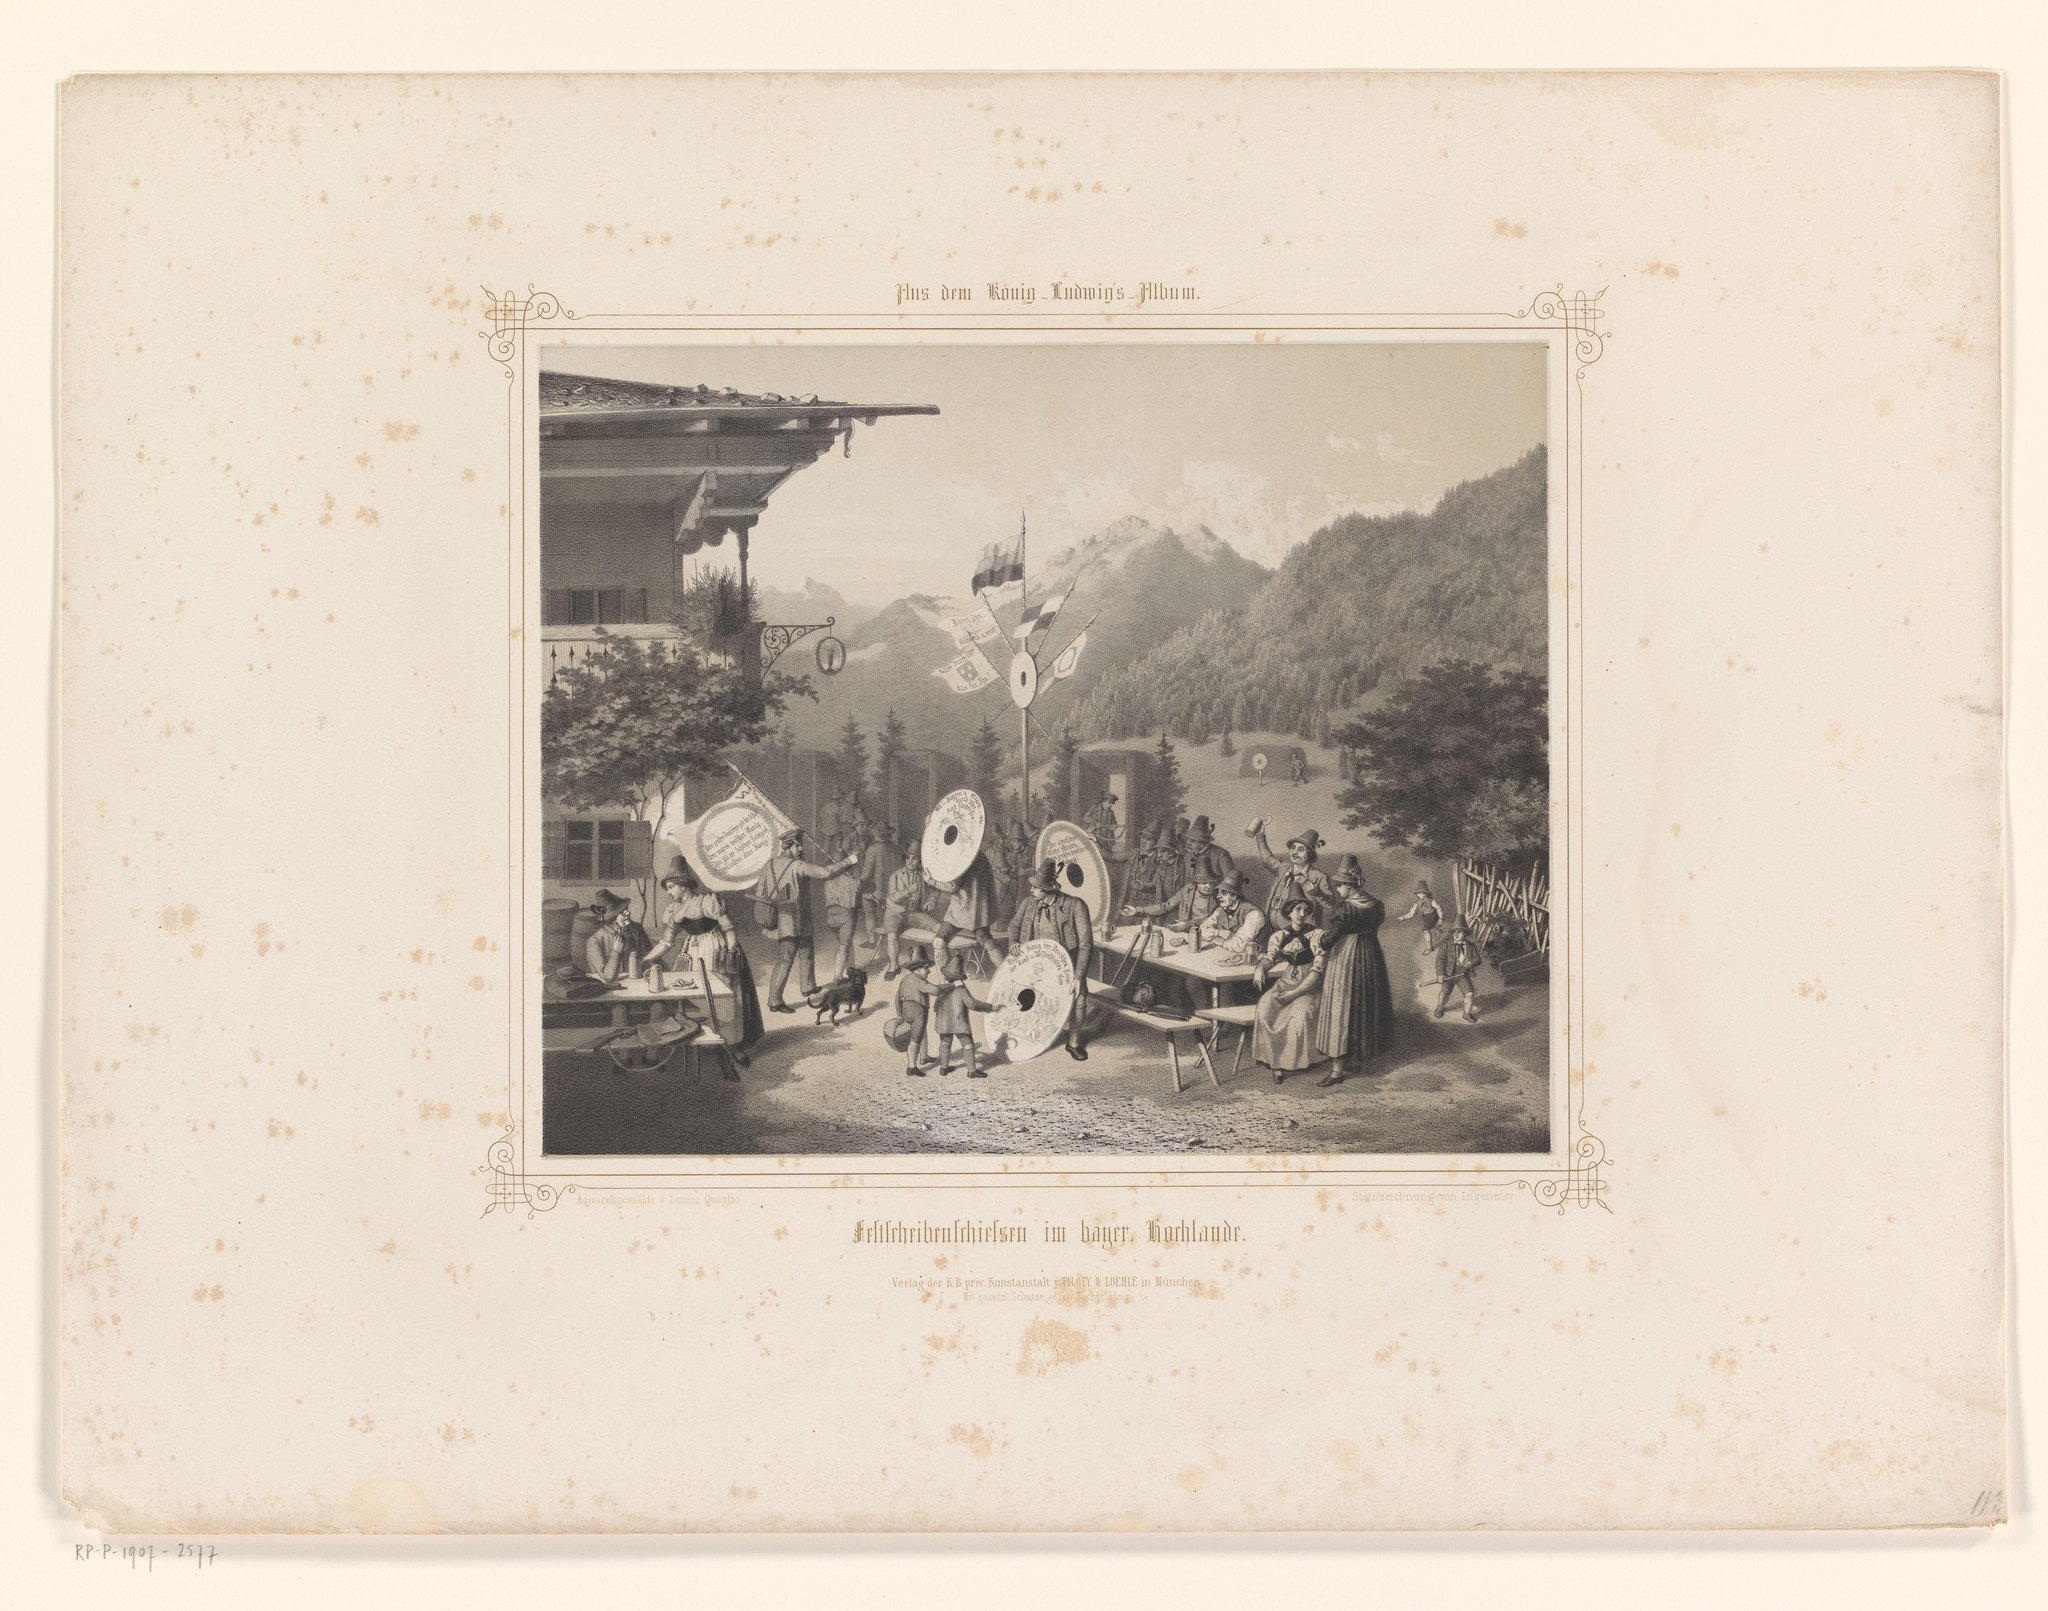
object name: print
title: König-Ludwigs Album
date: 1850-1859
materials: paper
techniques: tone lithography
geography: munich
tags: inn, coffee-house, public house, etc., landscapes (+ landscape with figures, staffage), festivities, shooting with bow and arrow, archery (~ games of skill)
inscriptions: check stamp: ‘Piloty&Loehle, München’, collector's mark: Lugt 2228, : ‘Mit gesetzl Schutze gegen Nachbildung’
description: Prent afkomstig uit de serie 'Album Seiner Majestät des Königs Ludwig I. von Bayern', verschenen in verschillende afleveringen. De prenten gaan terug op het album dat Lodewijk I van Beieren op 9 oktober 1850 kreeg overhandigd van verschillende kunstenaars.